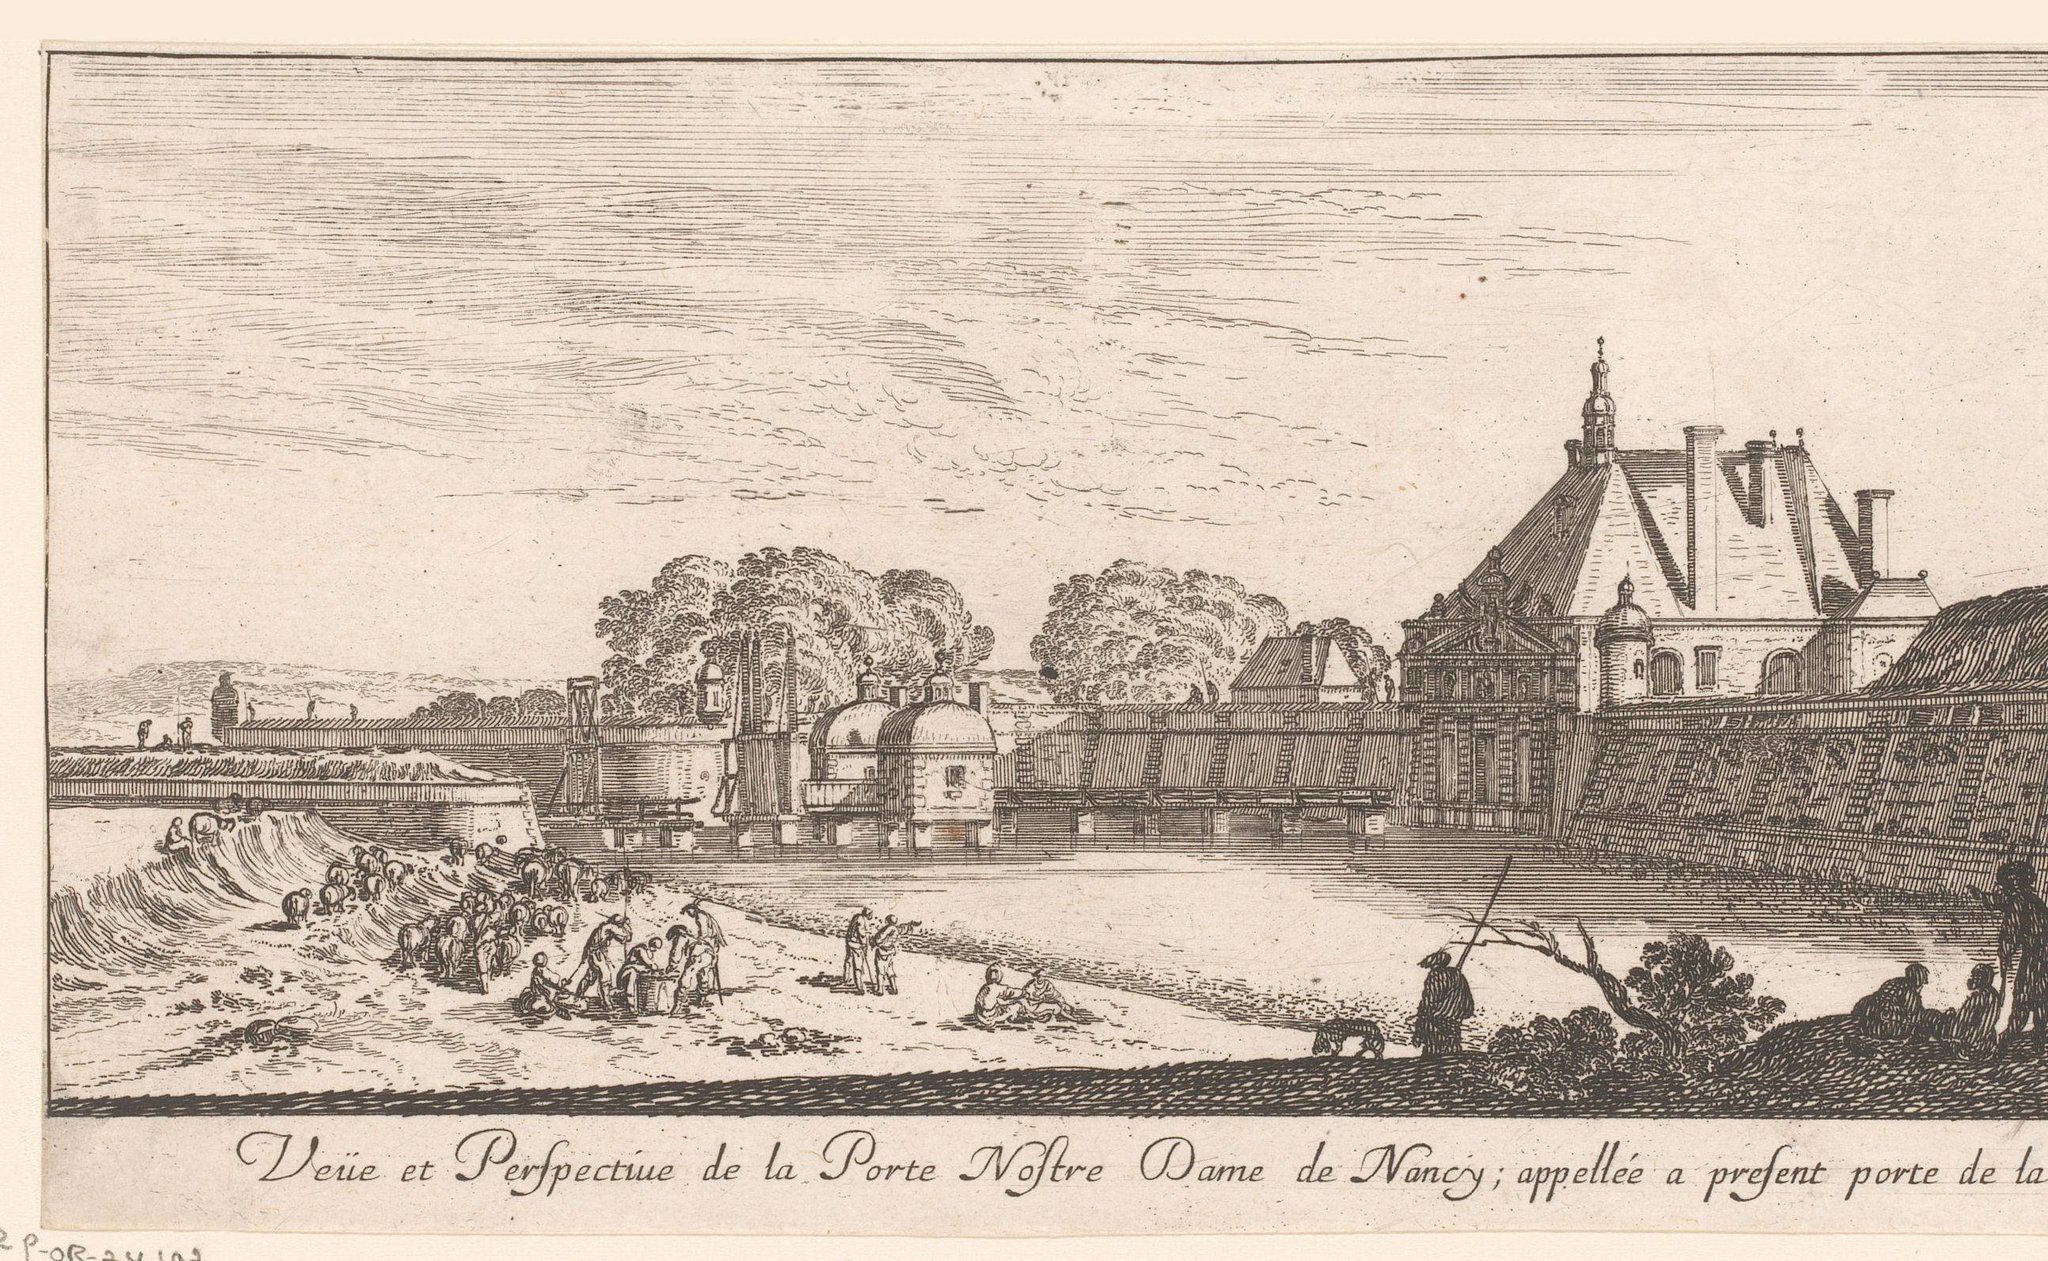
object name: print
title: Veue et Perspective de la Porte Nostre Dame de Nancy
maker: israël silvestre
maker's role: draughtsman, print maker, publisher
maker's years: 1621-1691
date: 1650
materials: paper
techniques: engraving, etching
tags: city-view, and landscape with man-made constructions, city-gate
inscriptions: collector's mark: Lugt 240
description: Prent maakt deel uit van een ongenummerde serie van dertien prenten.